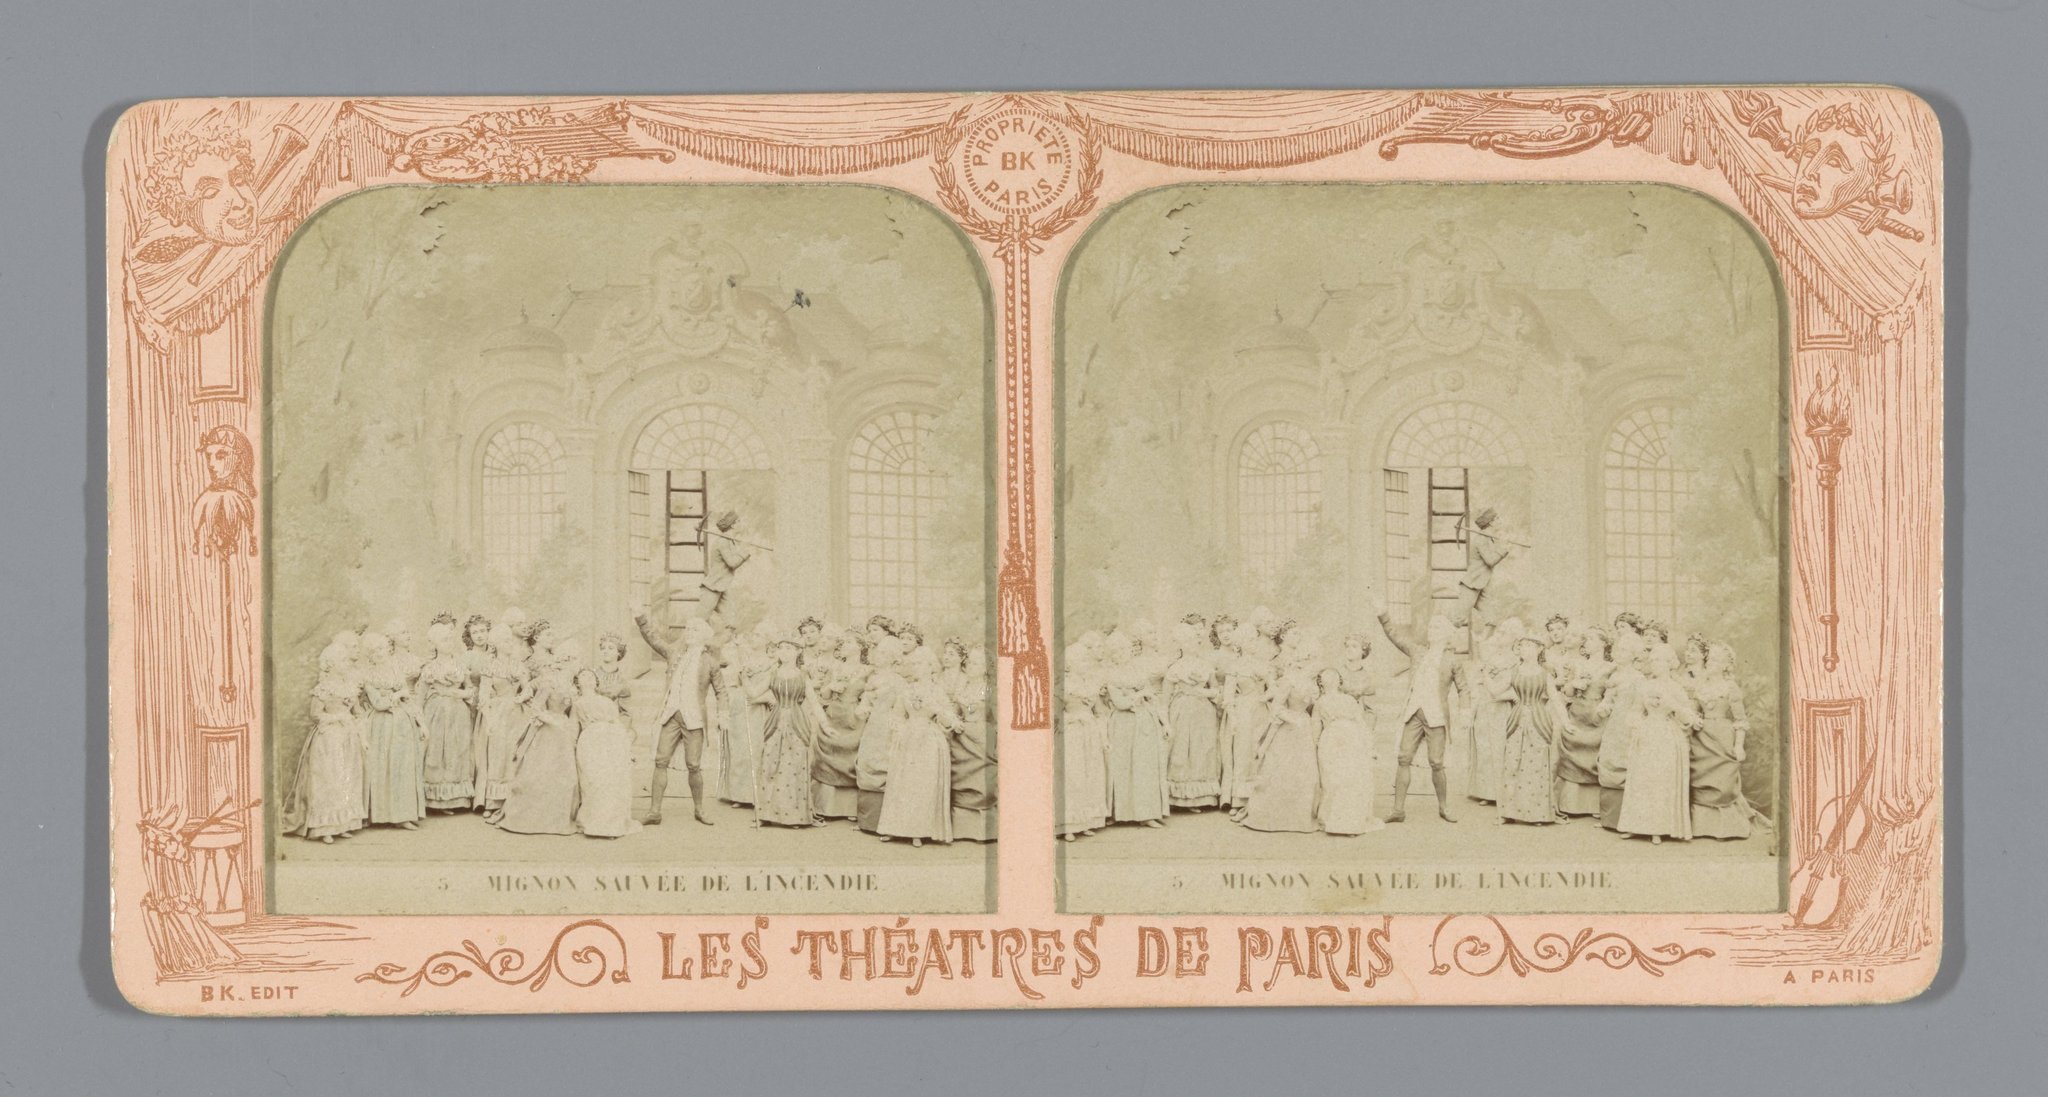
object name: stereograph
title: Mignon sauvée de l'incendie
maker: Anonymous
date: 1867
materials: cardboard, photographic support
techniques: albumen print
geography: paris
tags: group of actors, troupe; actors on the stage, paris